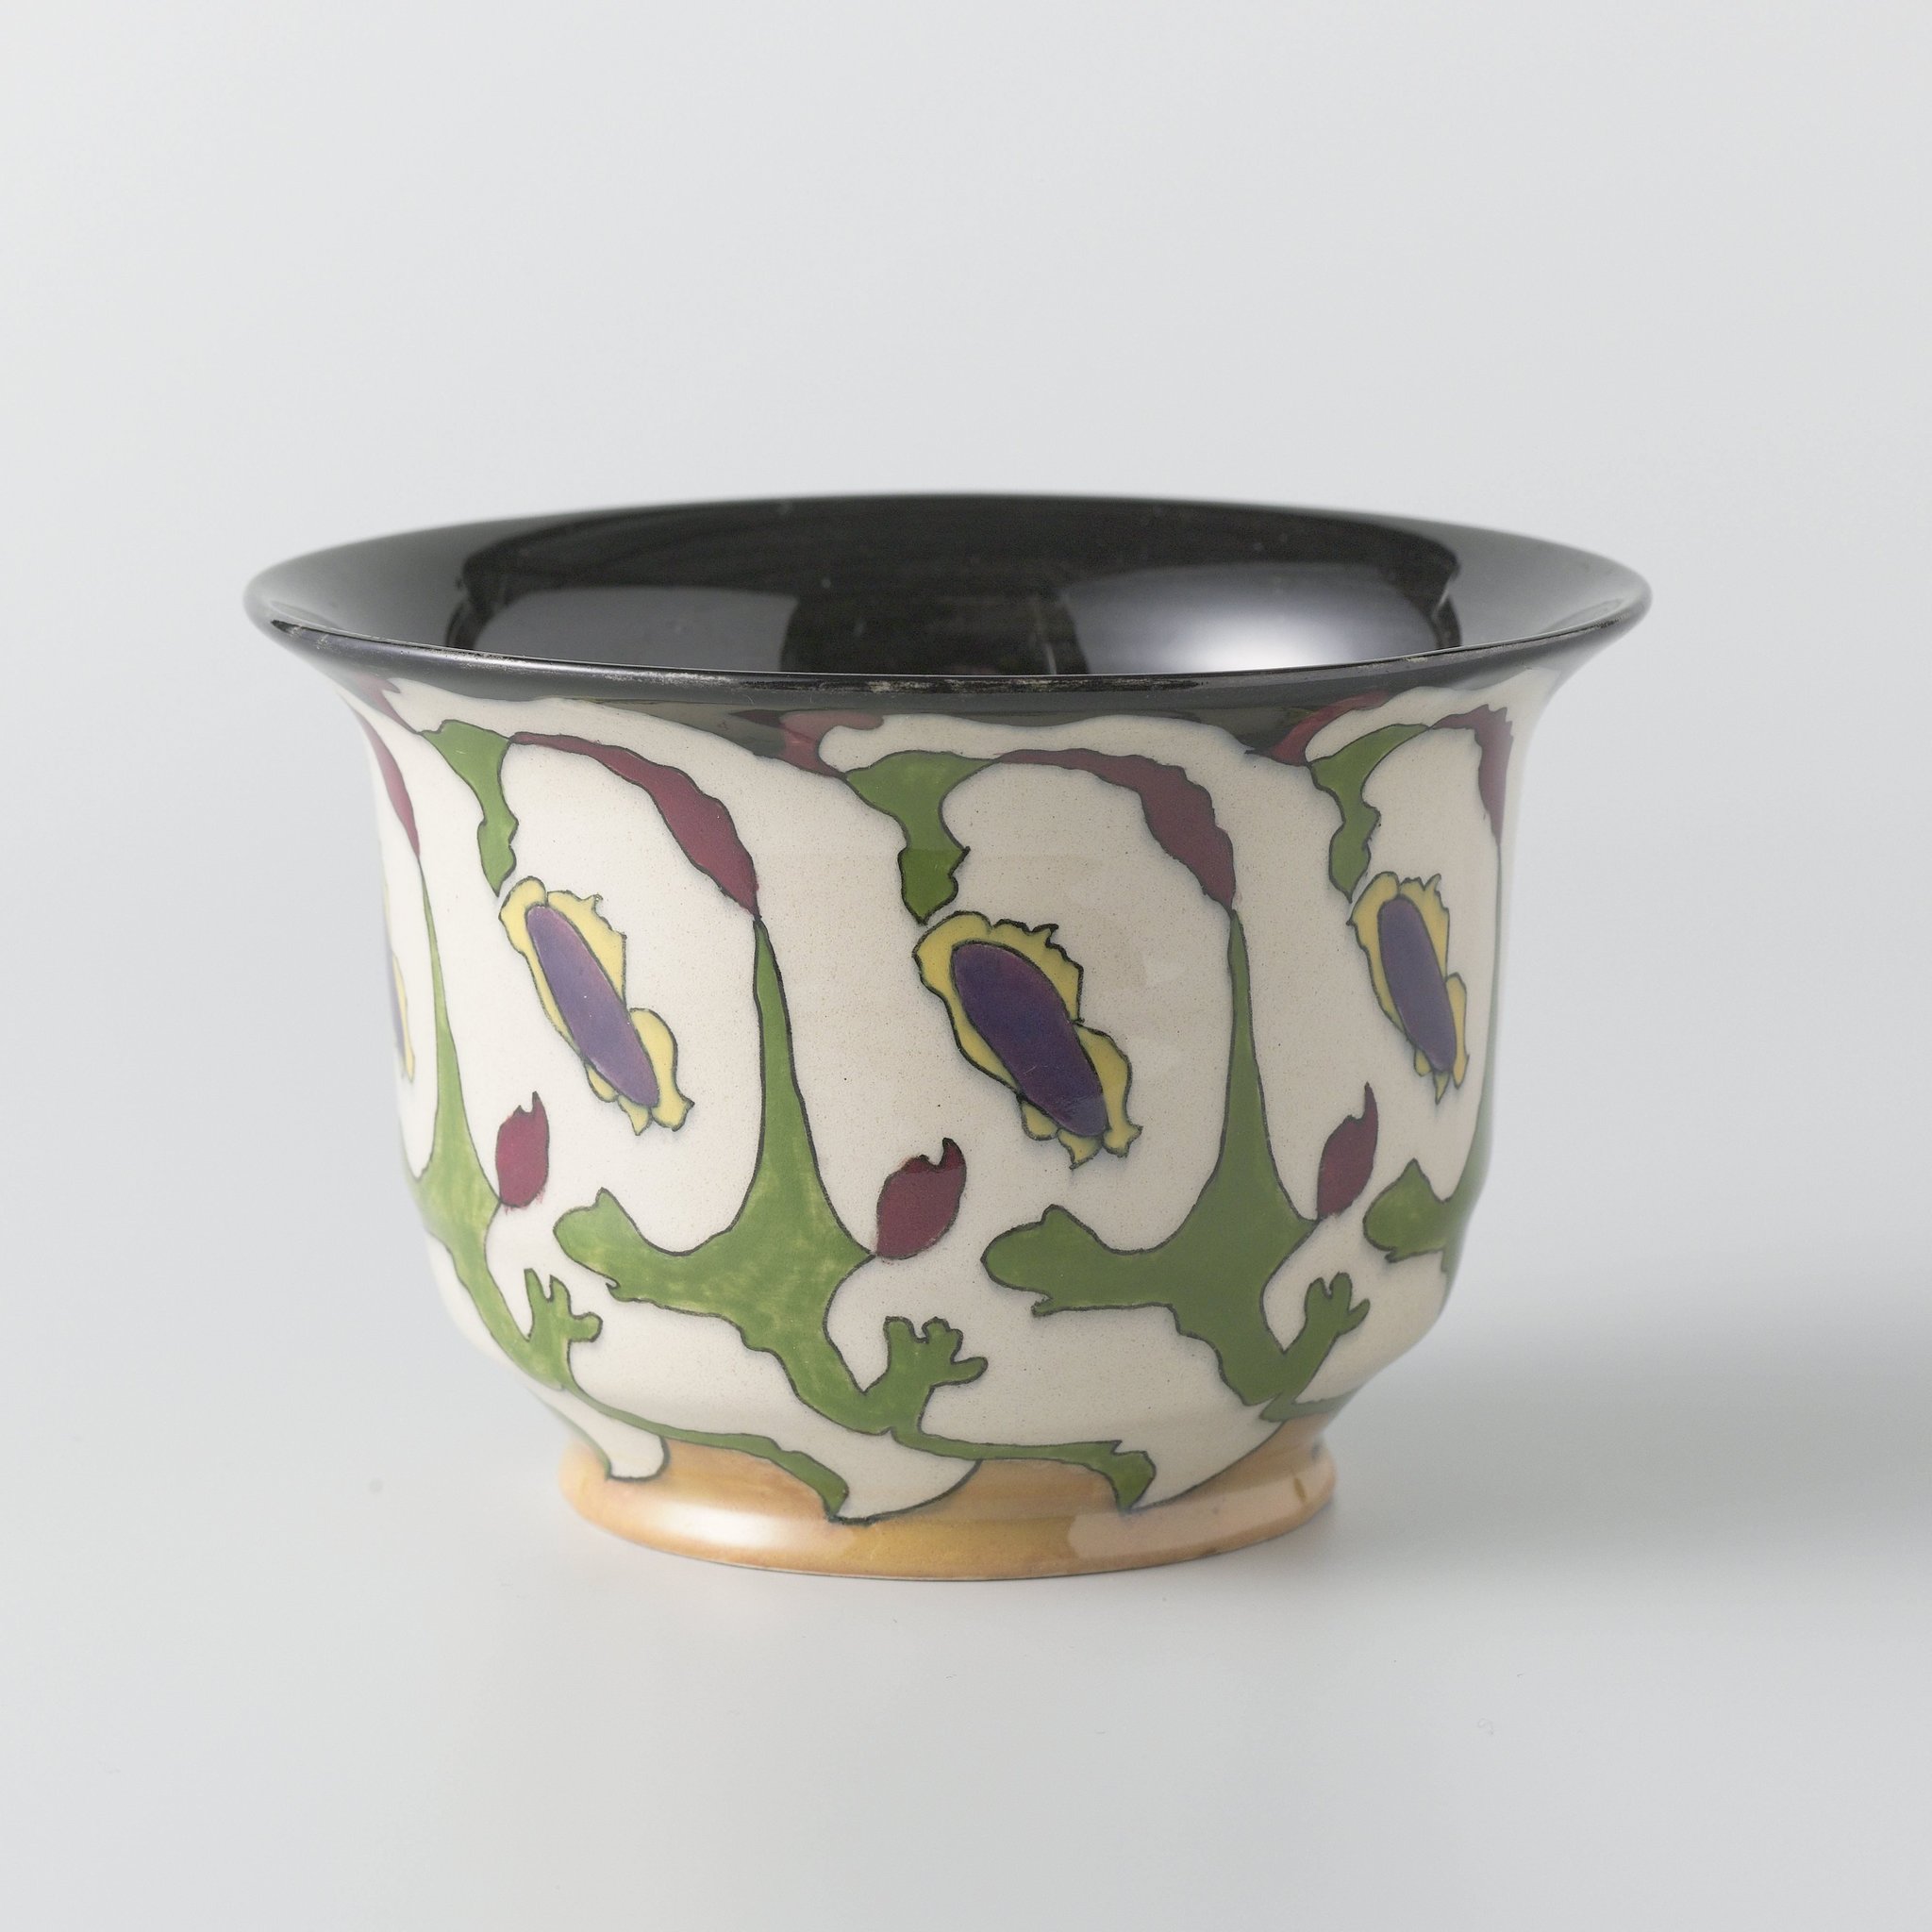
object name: bowl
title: Kom met decor "Naloop"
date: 1925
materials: earthenware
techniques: painted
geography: arnhem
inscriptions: mark: ‘rond fabrieksstempel; "Naloop"; 31 AP in zwart; ingegrift 12.’